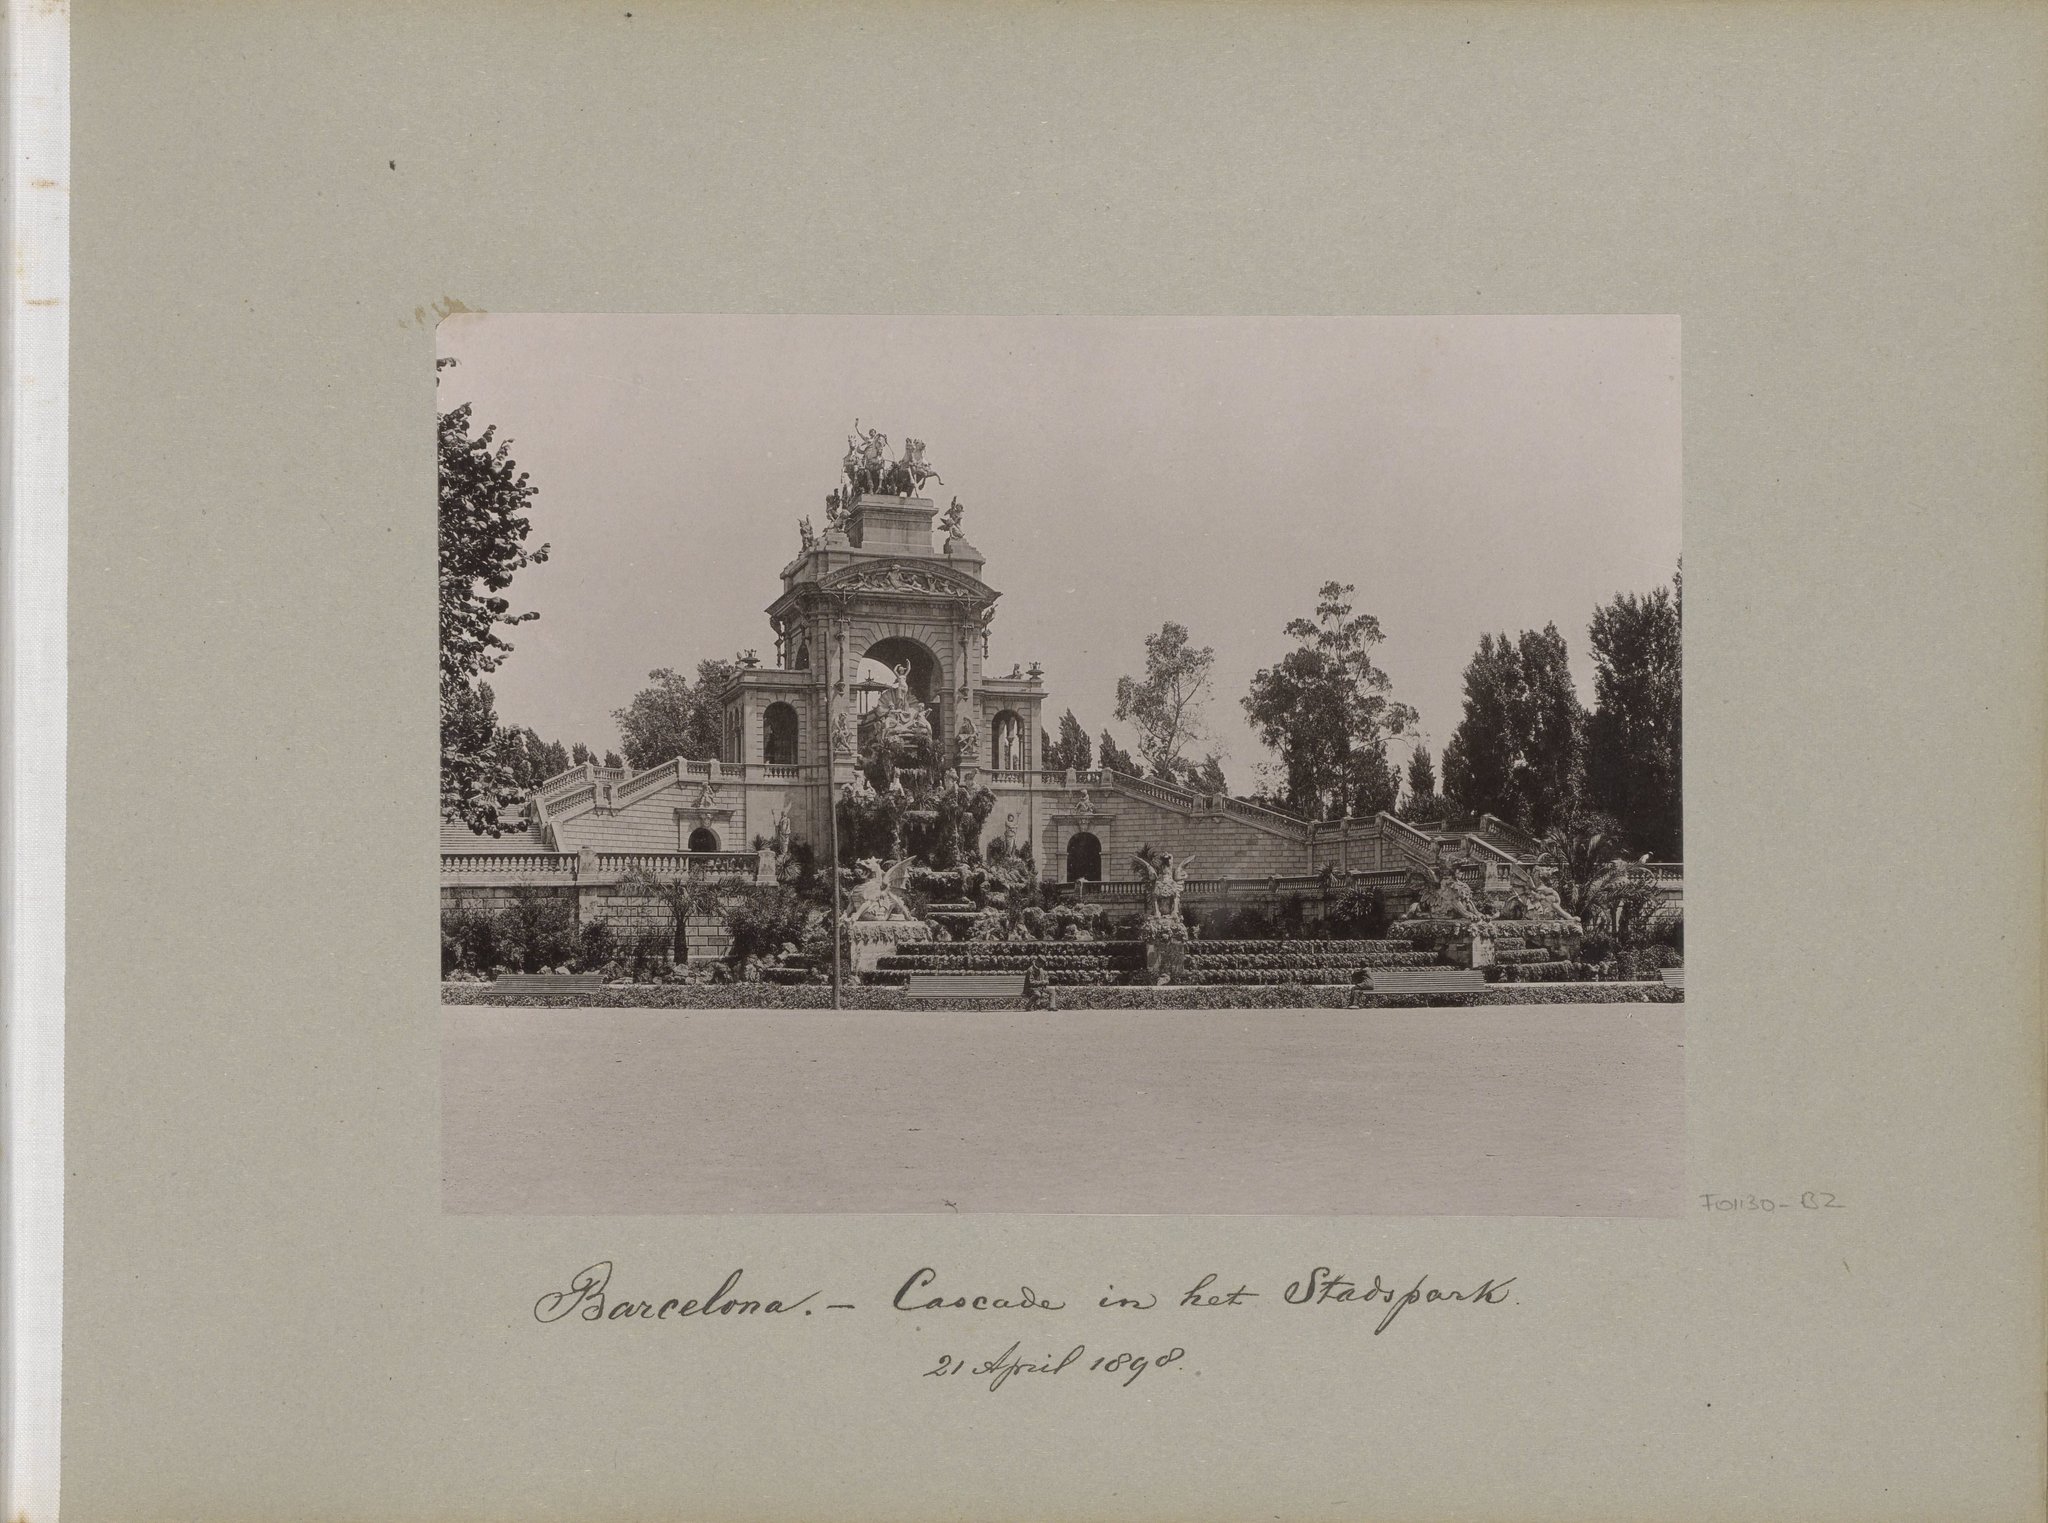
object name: album leaf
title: Cascadefontein en beelden in het stadspark van Barcelona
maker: Anonymous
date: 1880-1898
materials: paper, ink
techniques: photograph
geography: barcelona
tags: piece of sculpture, reproduction of a piece of sculpture (+ sculpture), ornamental fountain (+ city(-scape) with figures, staffage), public gardens, park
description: Onderdeel van Reisalbum met foto's van bezienswaardigheden in Frankrijk, Spanje, Italië, Duitsland, Zwitserland en Oostenrijk.